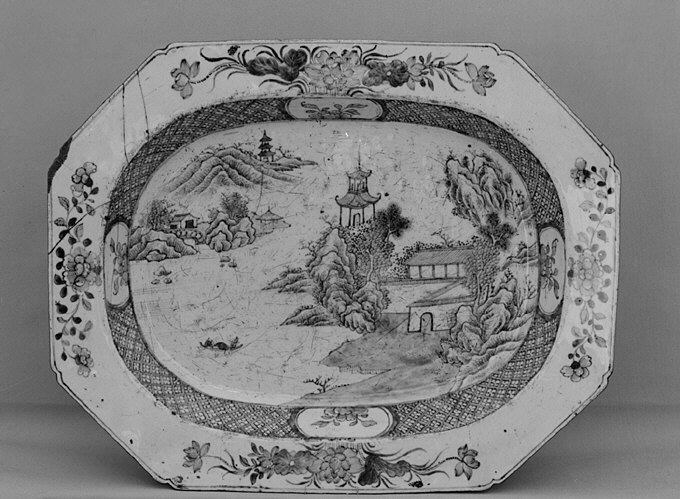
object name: dish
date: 1745-1755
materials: hard paste porcelain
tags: houses,flowers,landscapes